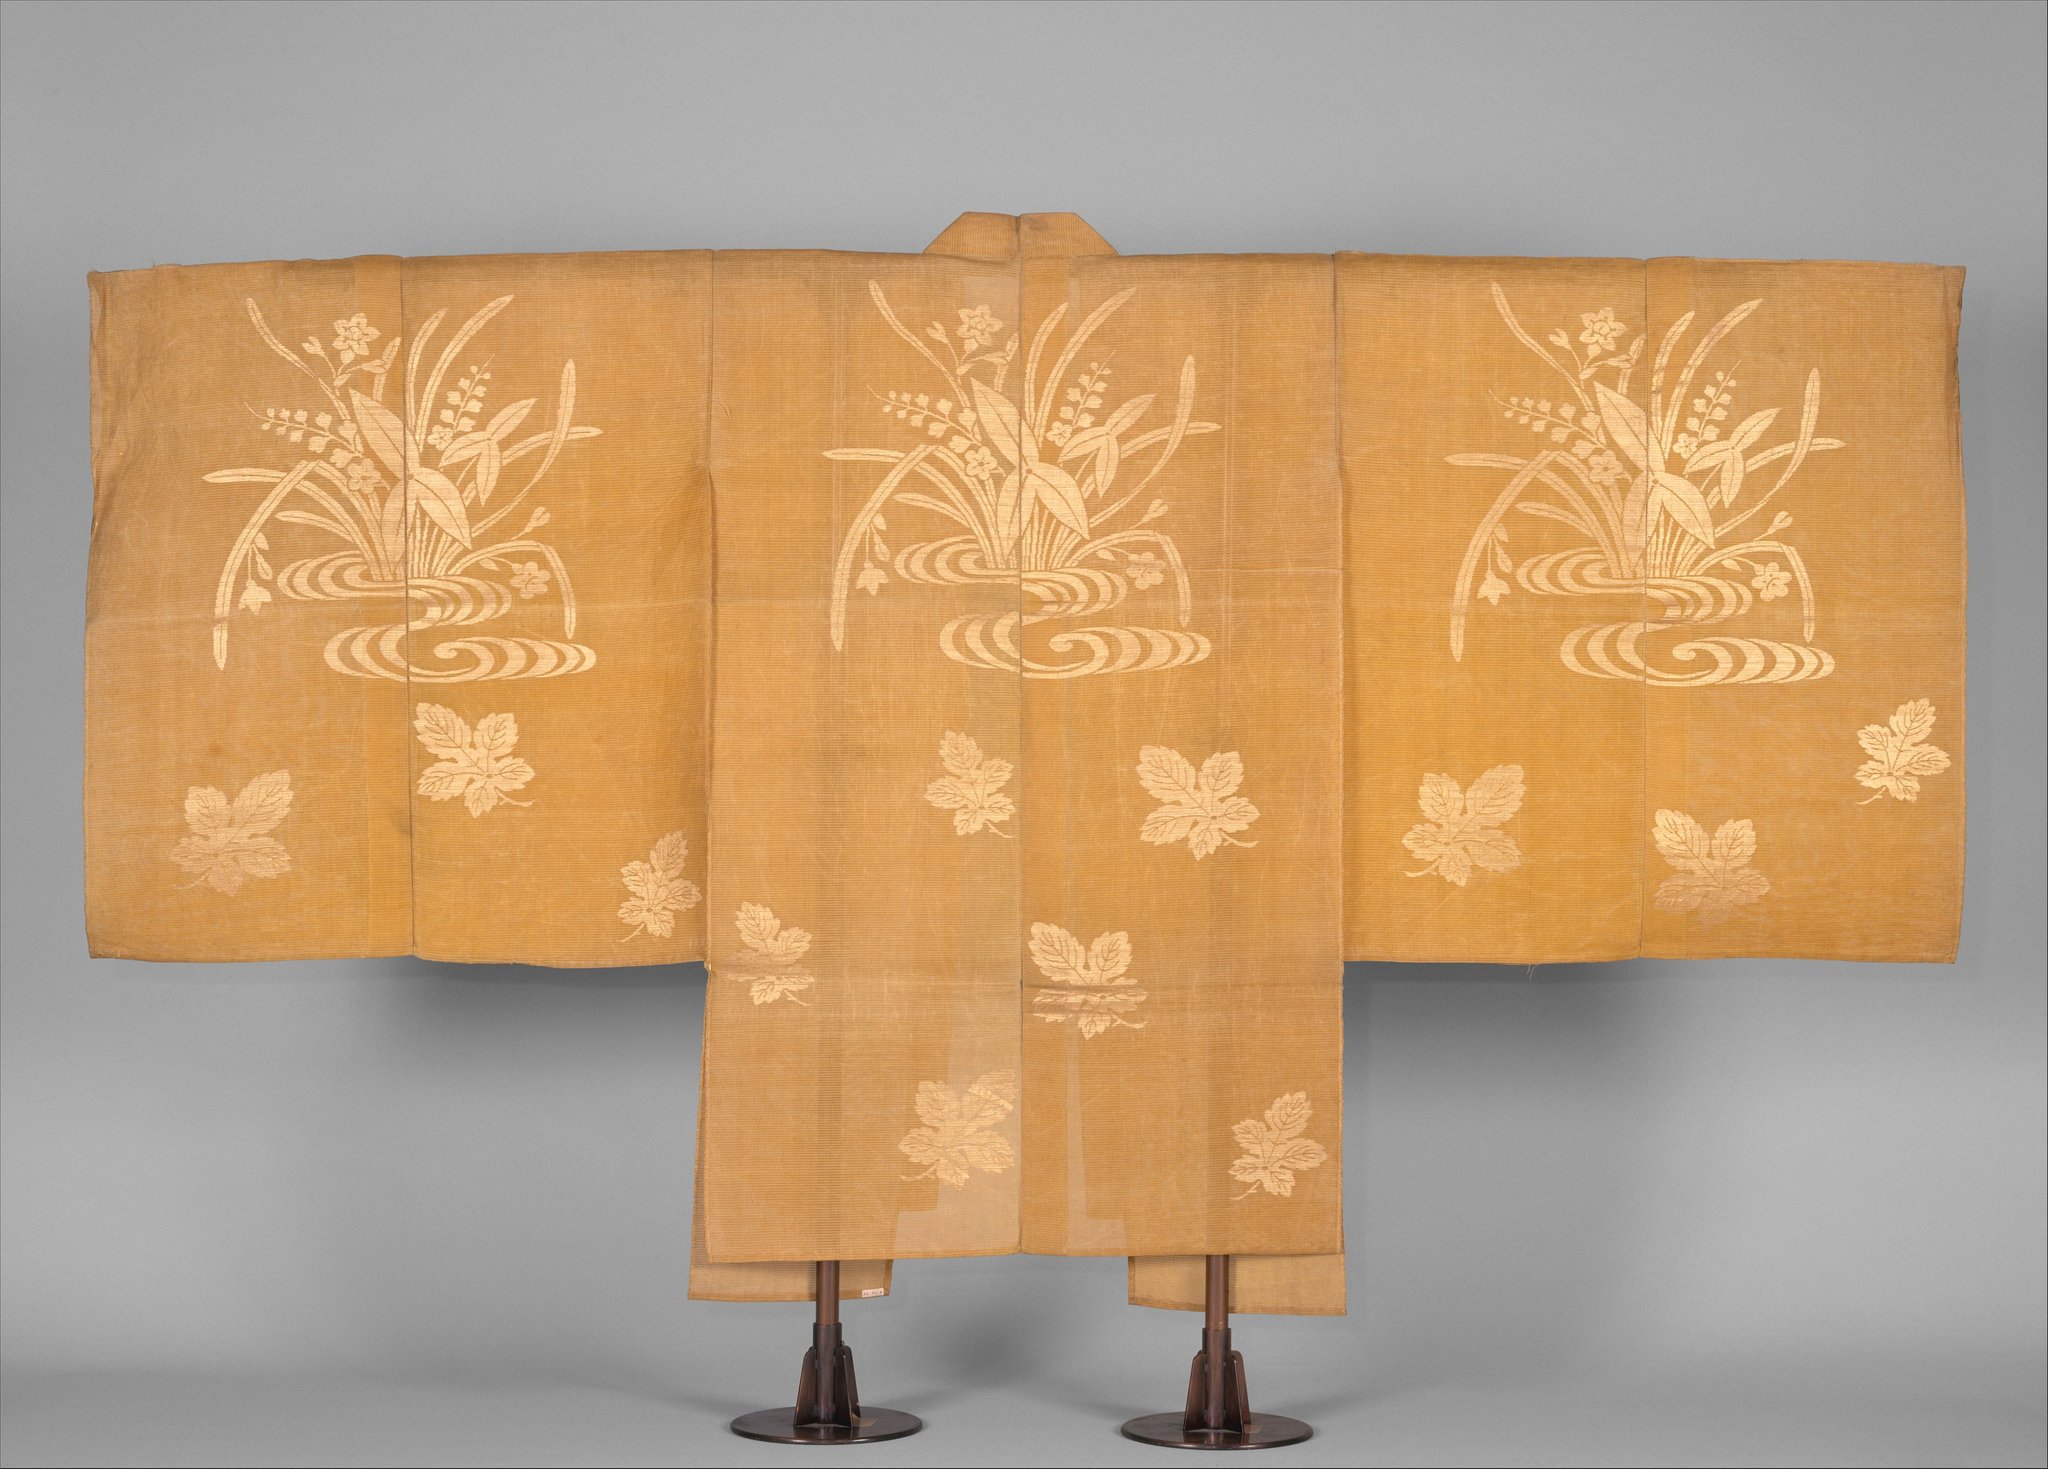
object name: noh costume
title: Noh Costume (Chōken) with Water Plants and Mulberry Leaves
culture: japanese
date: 1701-1800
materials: textile, metal thread, silk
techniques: brocade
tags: plants,leaves